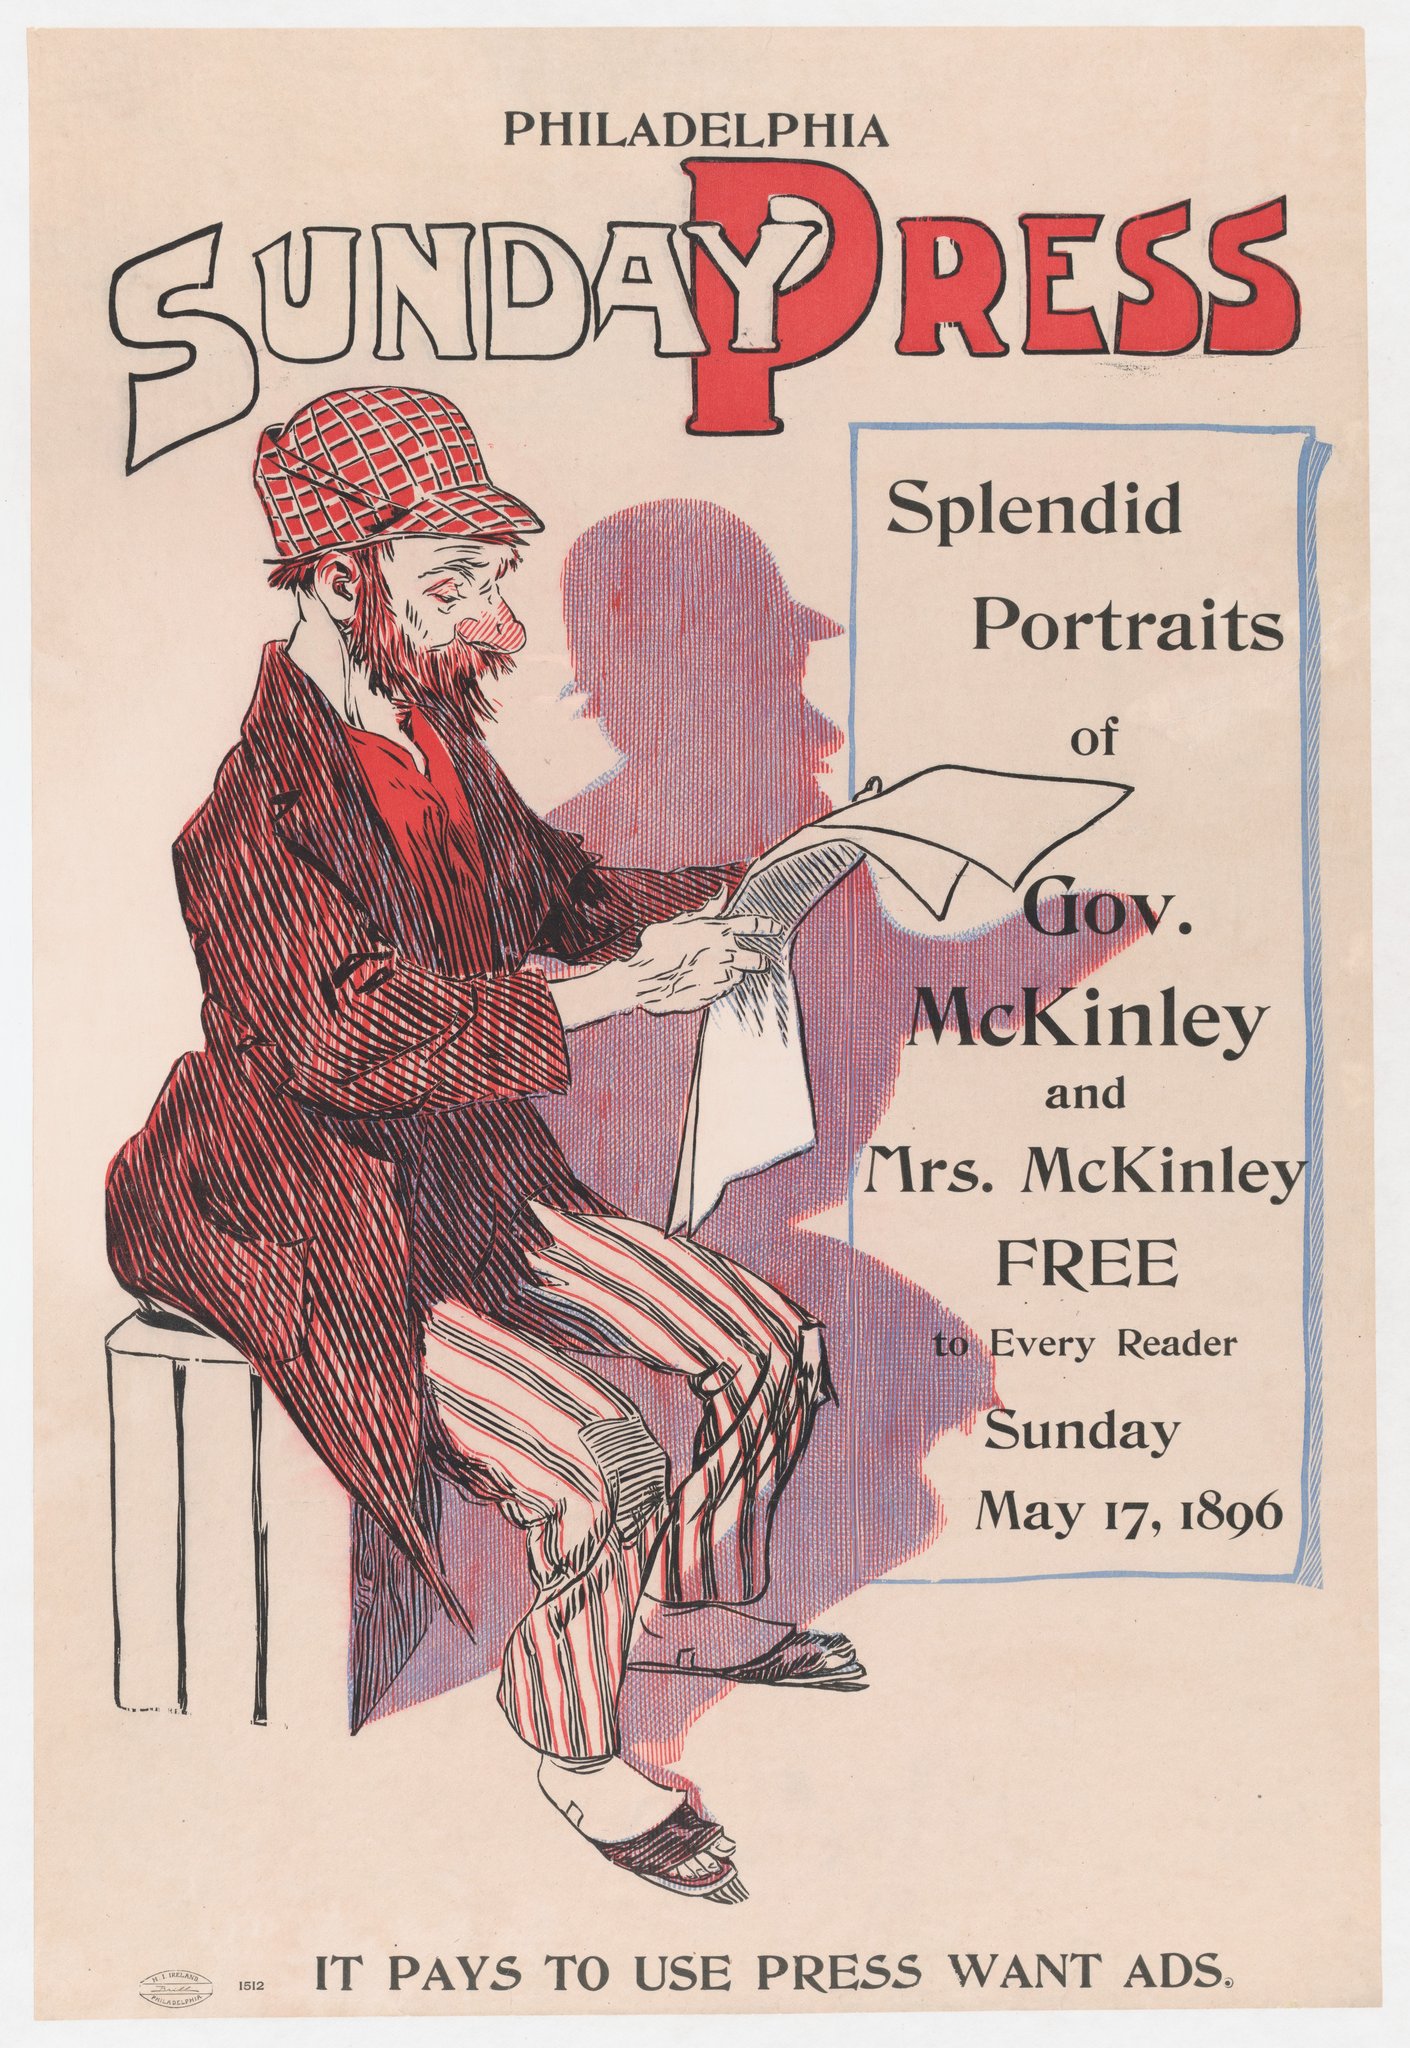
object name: poster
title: Advertisement for Philadelphia Sunday Press, May 17, 1896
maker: george reiter brill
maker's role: artist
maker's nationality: american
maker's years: 1867-1918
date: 1896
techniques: lithograph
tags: men,reading,advertisements